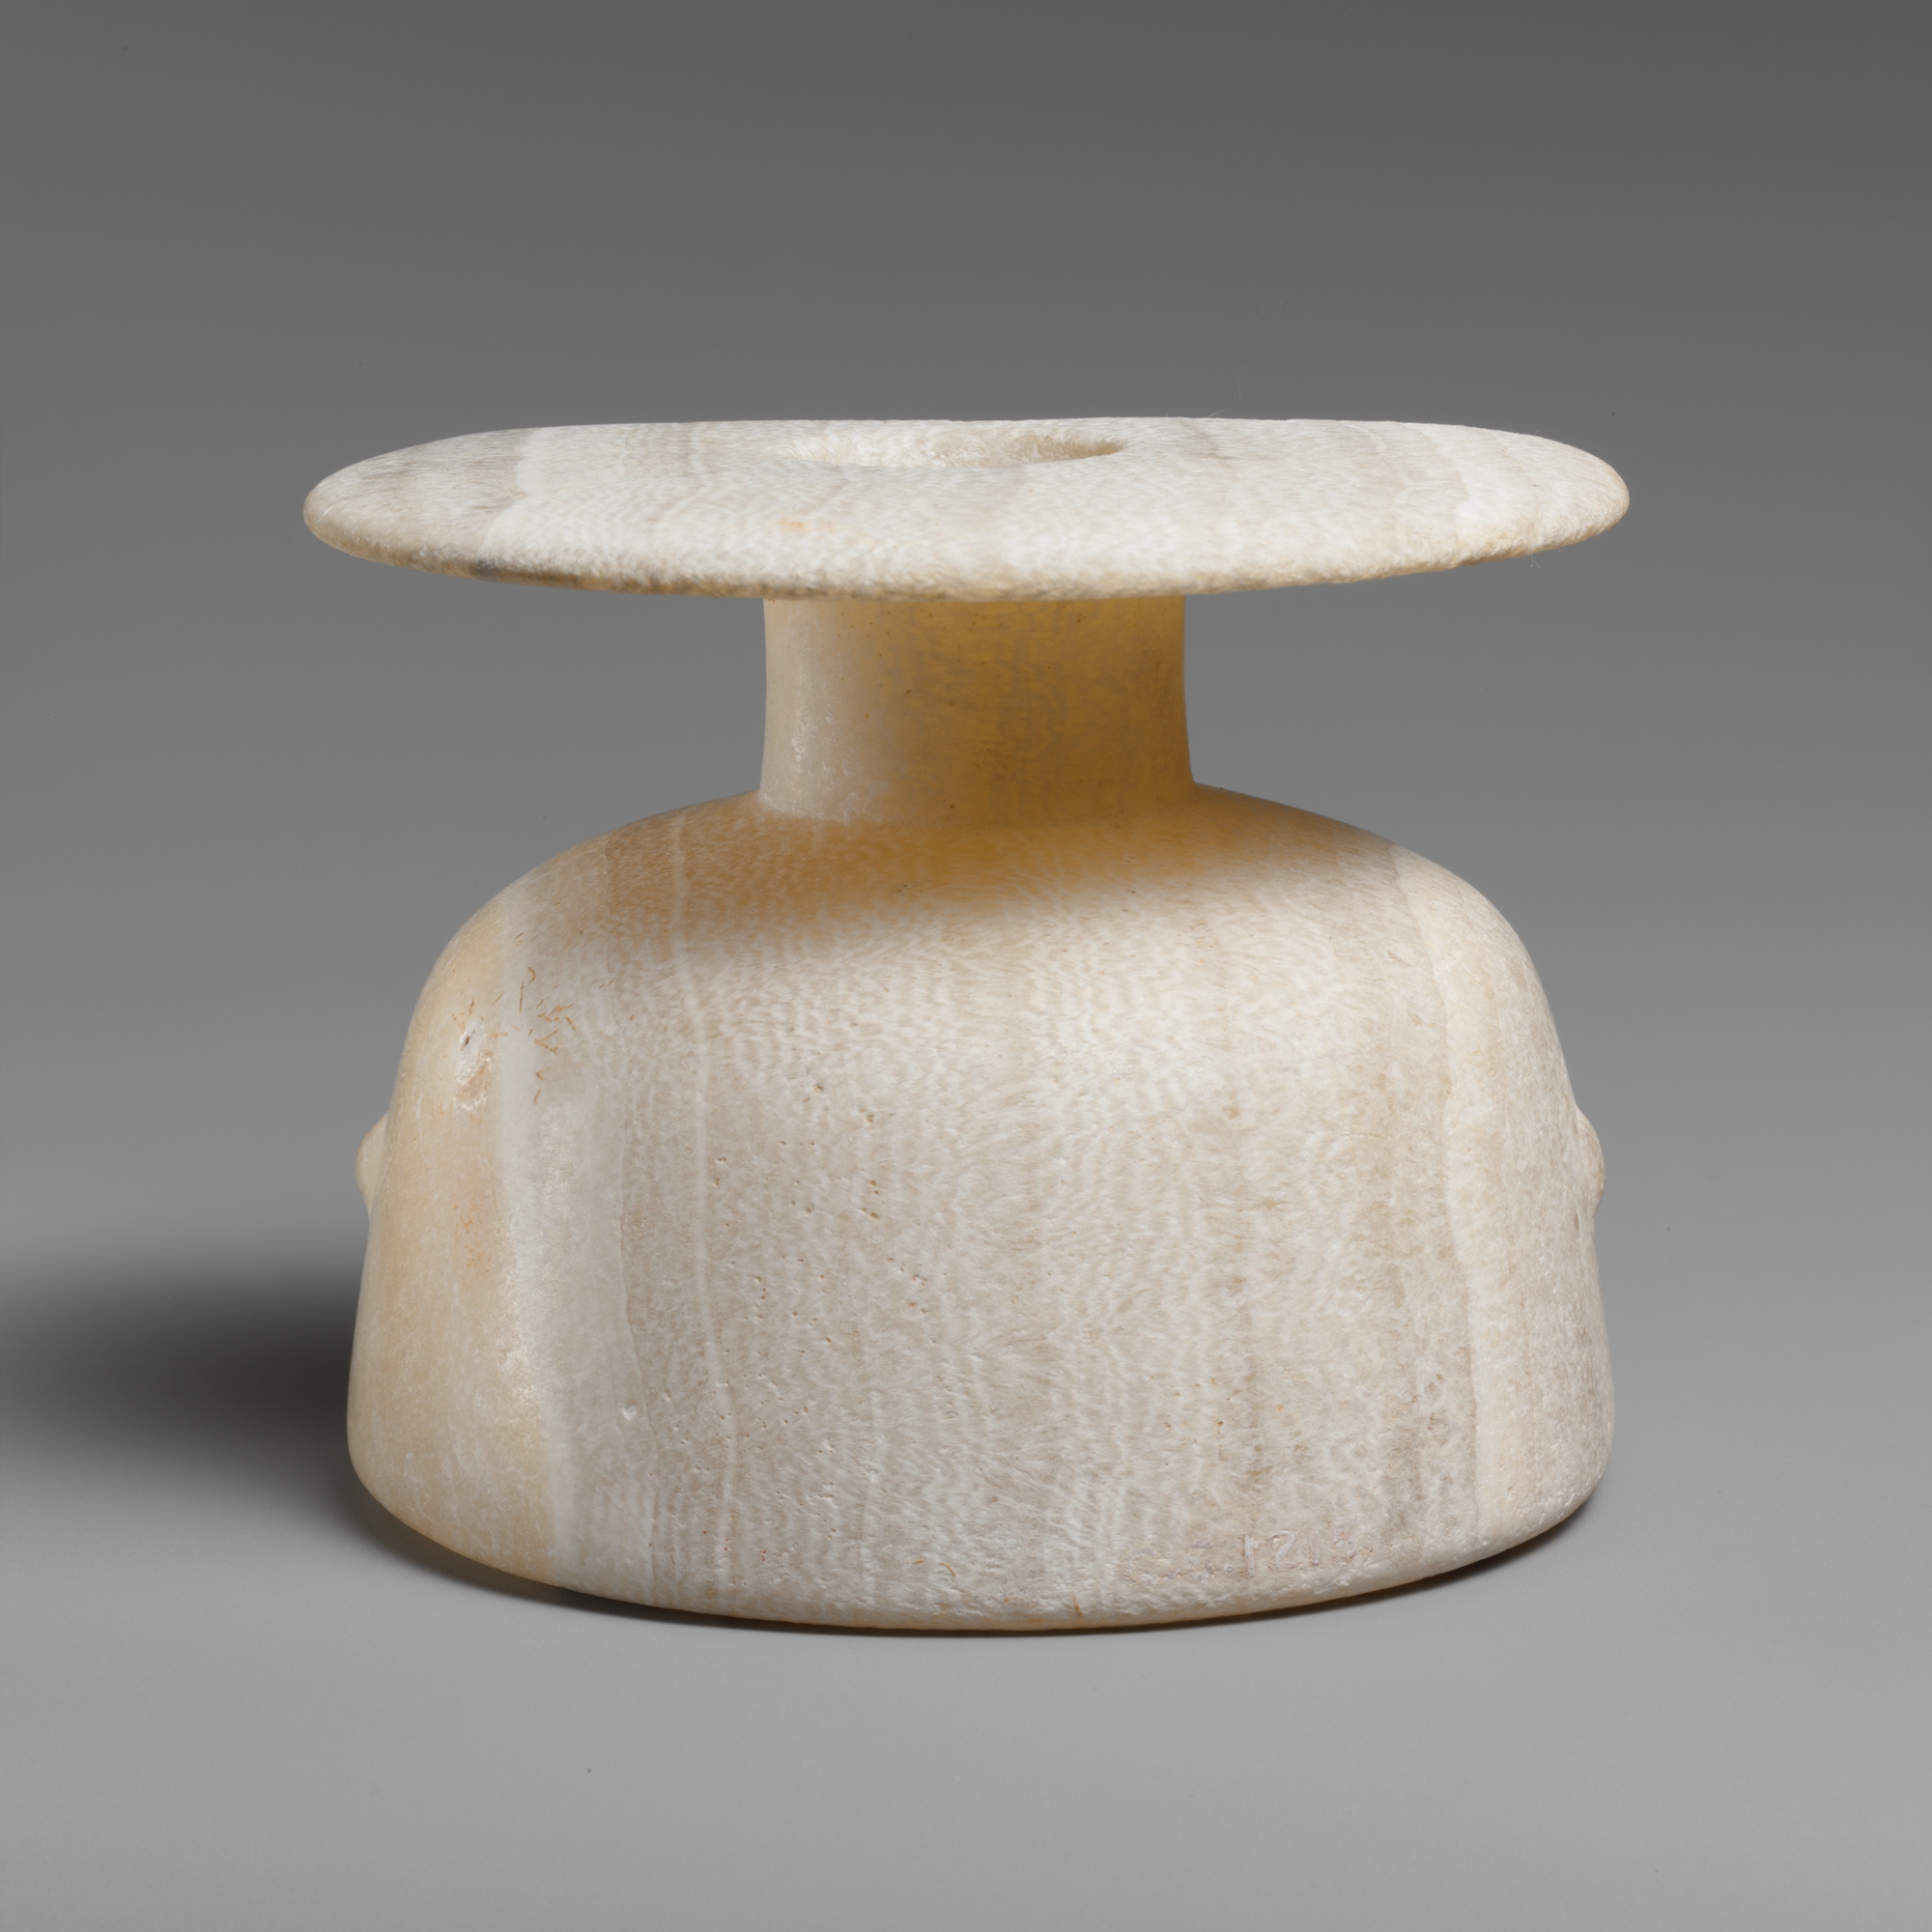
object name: flask with broad lip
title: Alabaster flask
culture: cypriot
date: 334-201 BCE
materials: gypsum